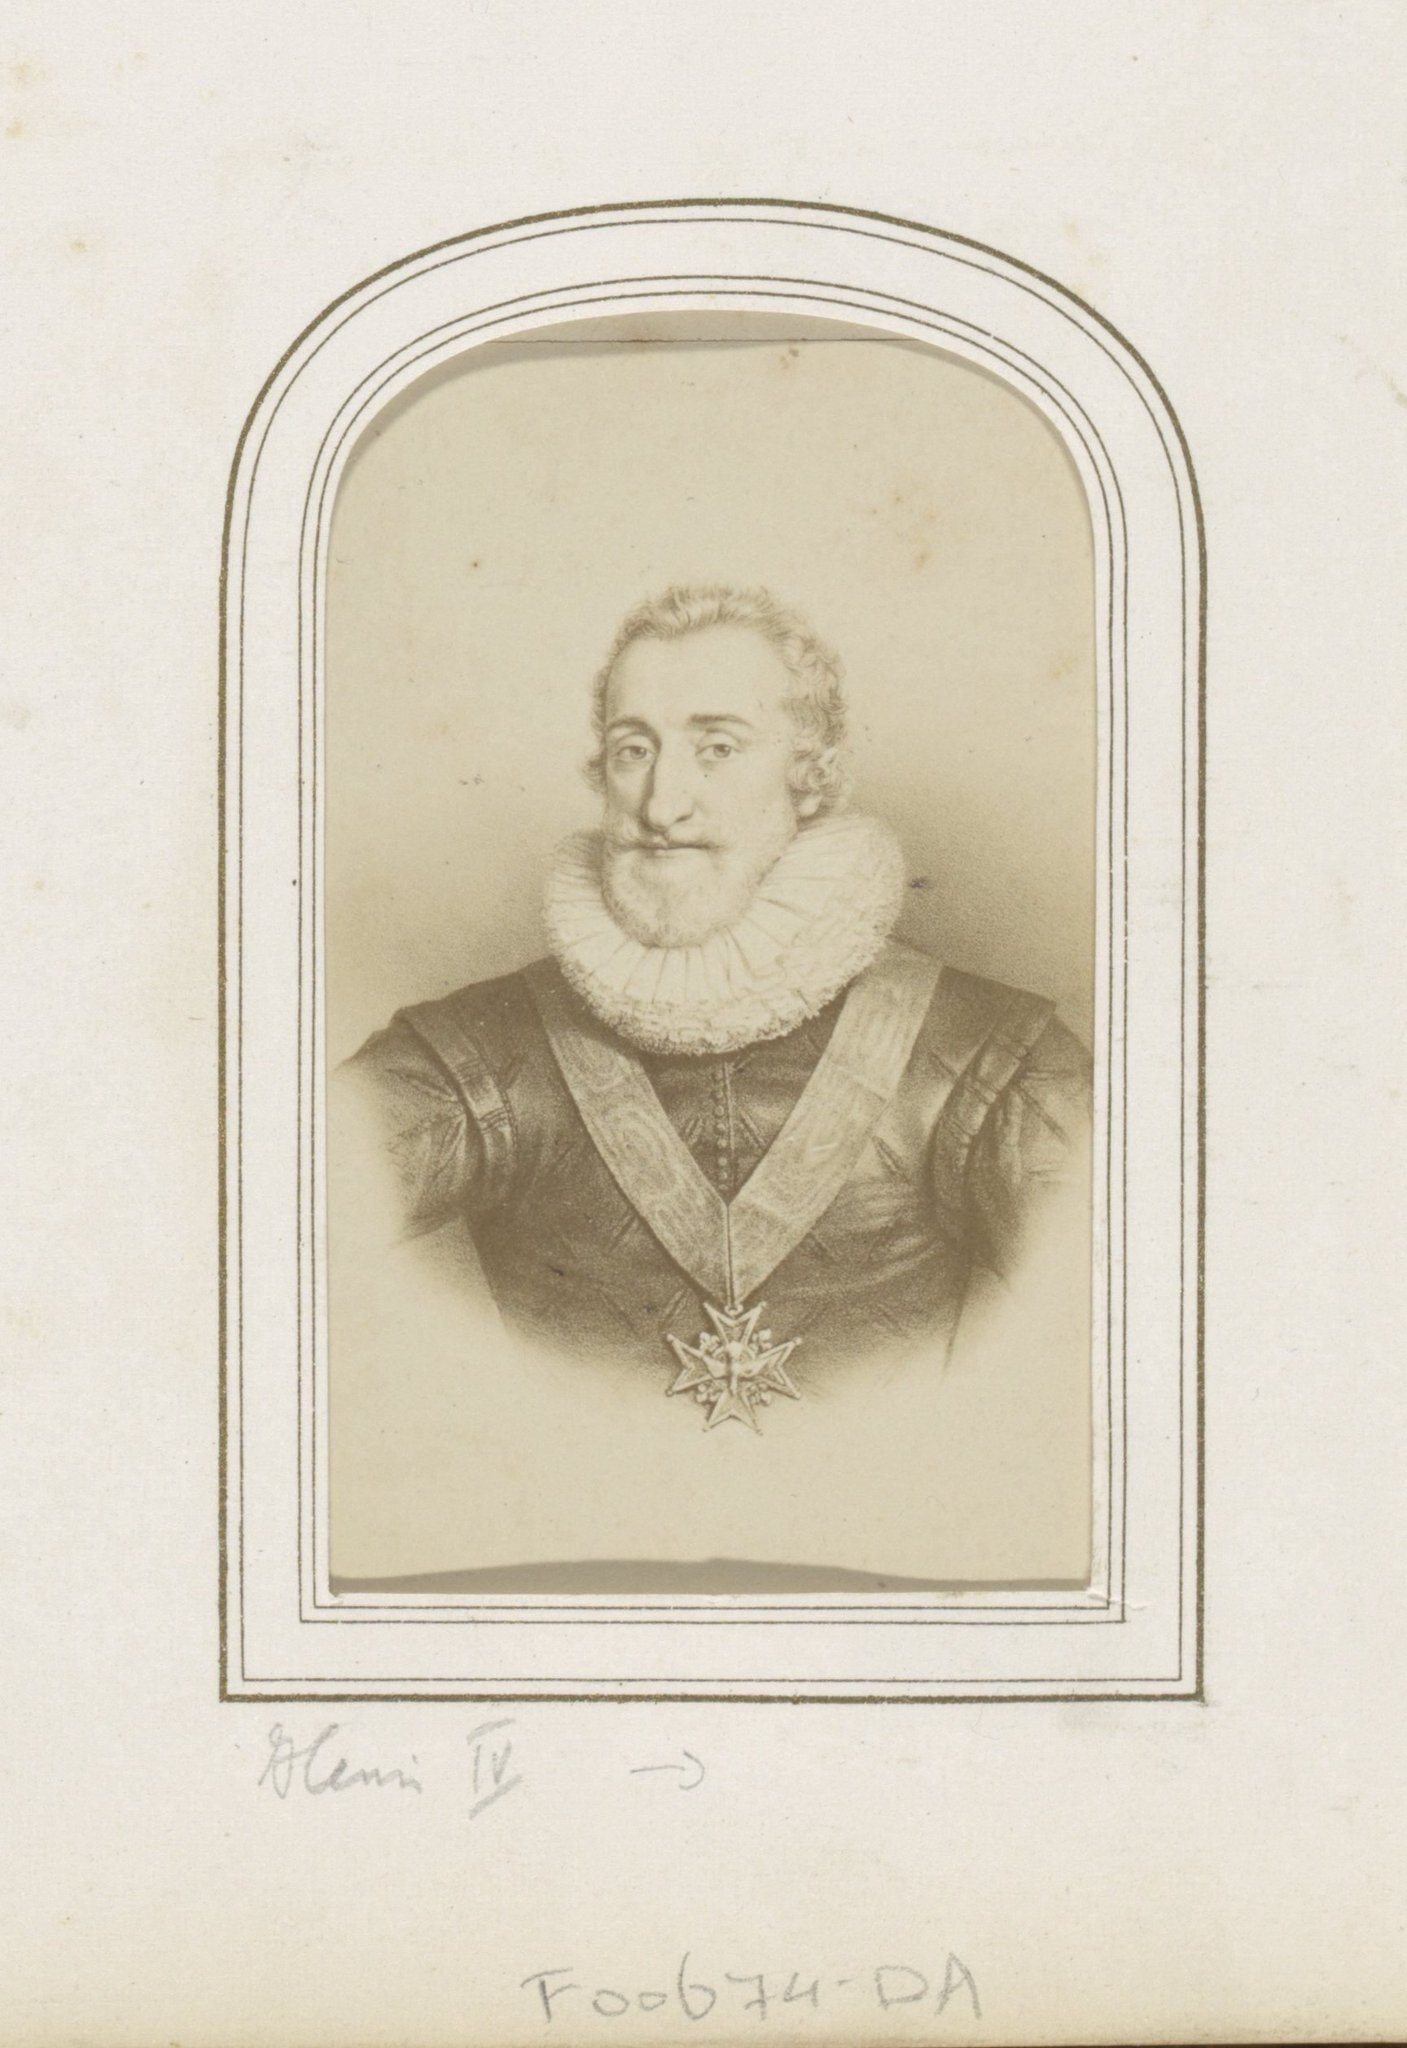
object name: carte de visite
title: Henri IV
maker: Anonymous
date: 1855-1880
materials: cardboard, paper, photographic support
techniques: albumen print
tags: paris, hendrik iv (koning van frankrijk en navarra), historical persons, clothing for the upper part of the body, ruler, sovereign, decorations, honours (as symbols of the state, etc.), beard, neck-gear: collar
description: Onderdeel van Fotoalbum met 123 cartes-de-visite van leden van Europese vorstenhuizen, politici en bekende personen.